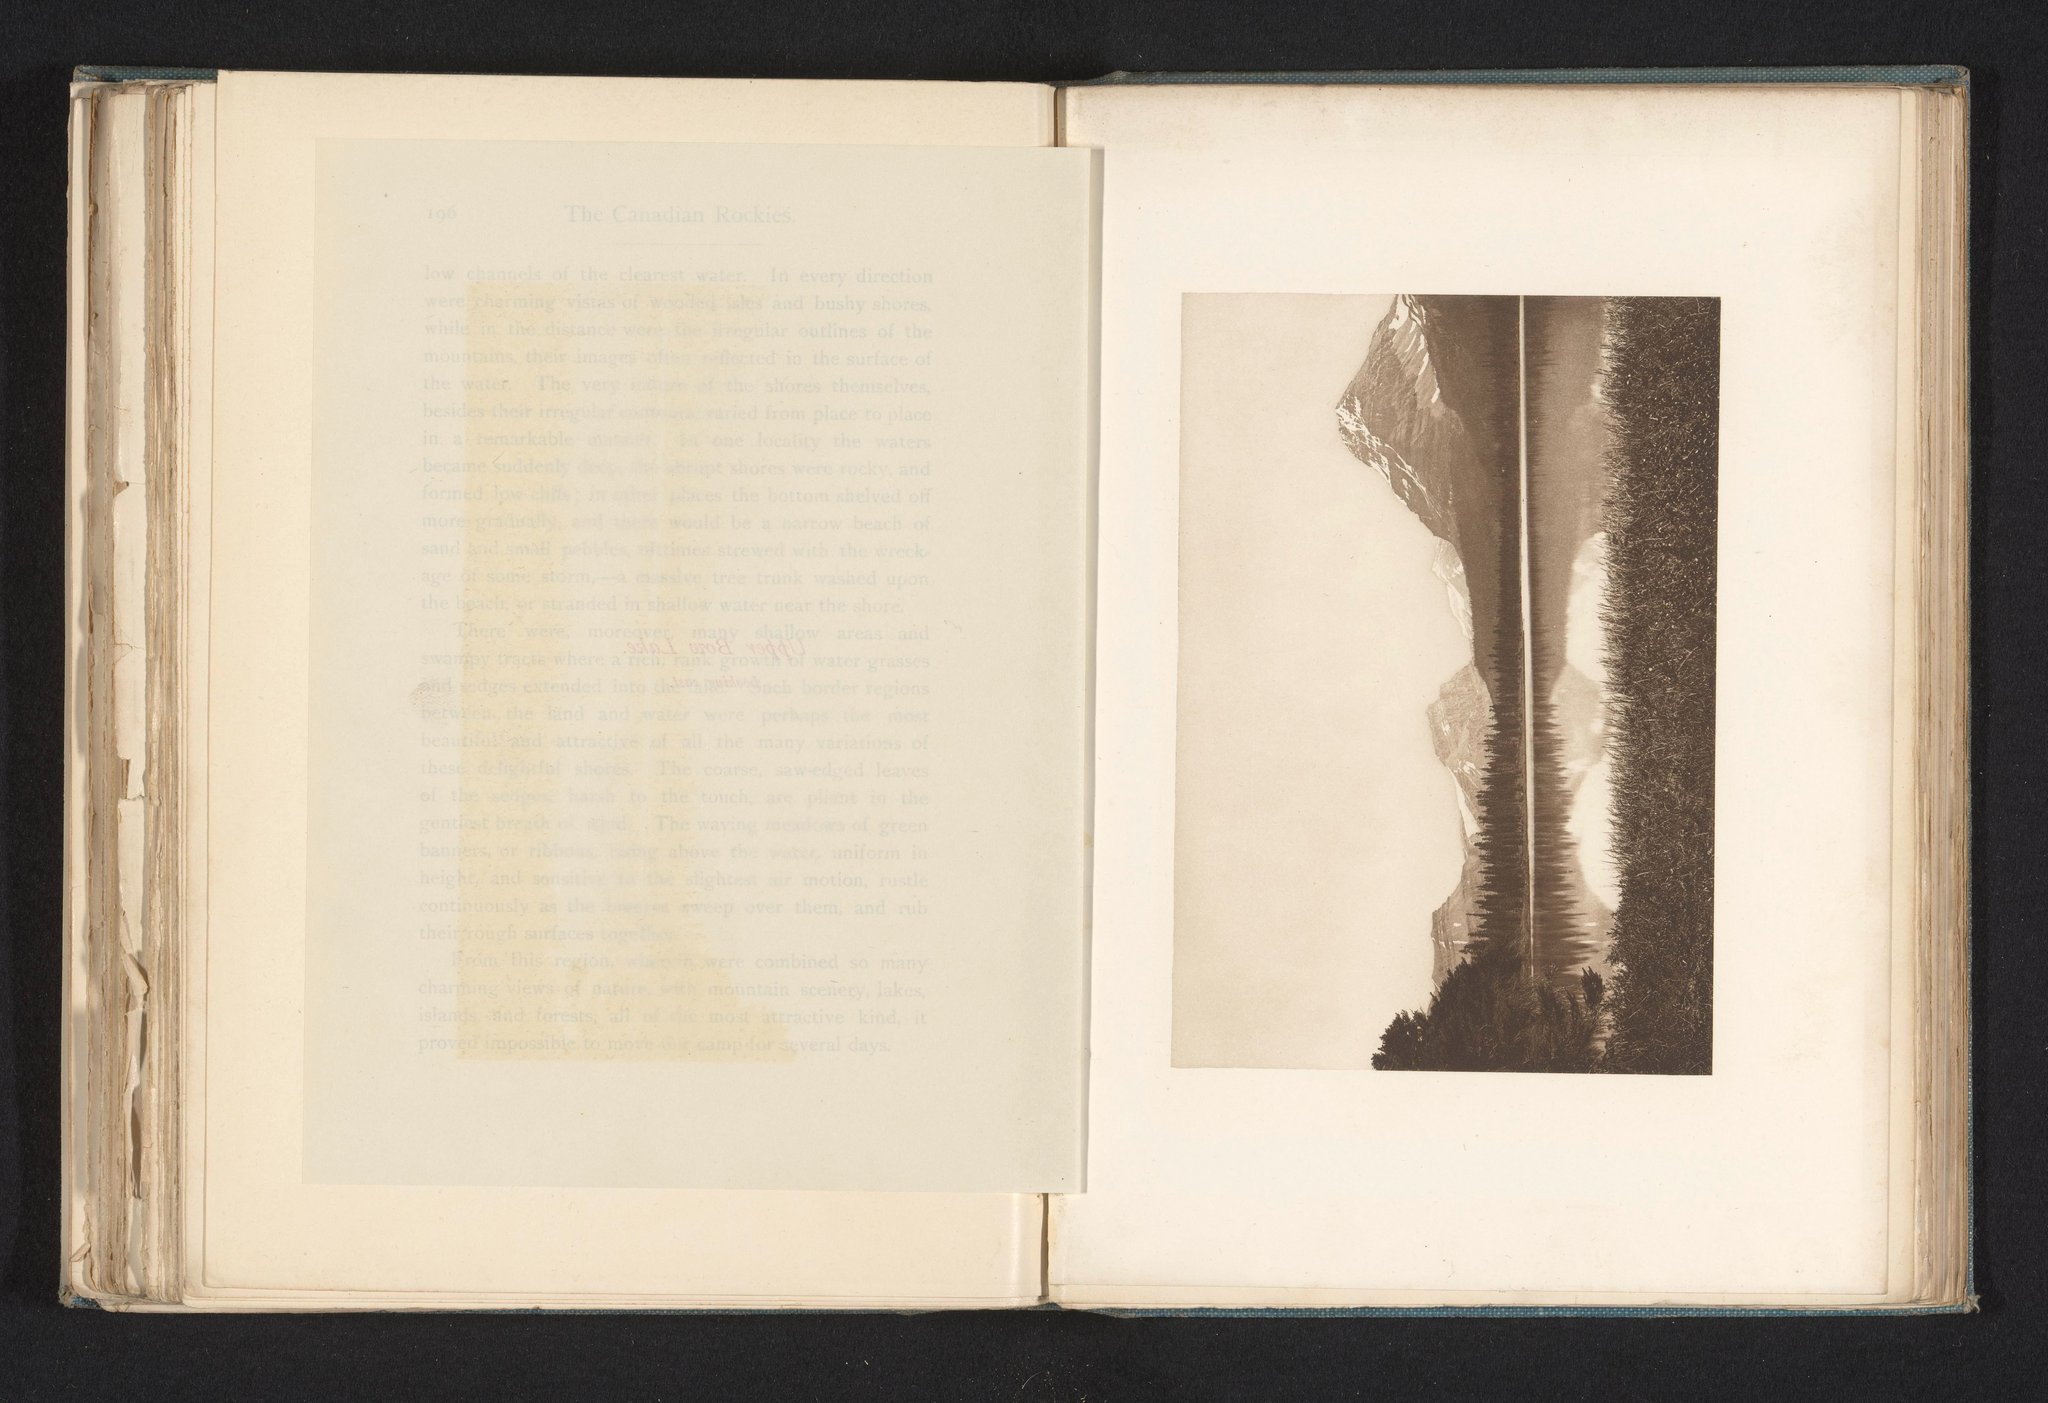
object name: photomechanical print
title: Gezicht op Bow Lake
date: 1893-1897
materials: paper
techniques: photoaquatint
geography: alberta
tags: lake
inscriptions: title: ‘Upper Bow Lake’